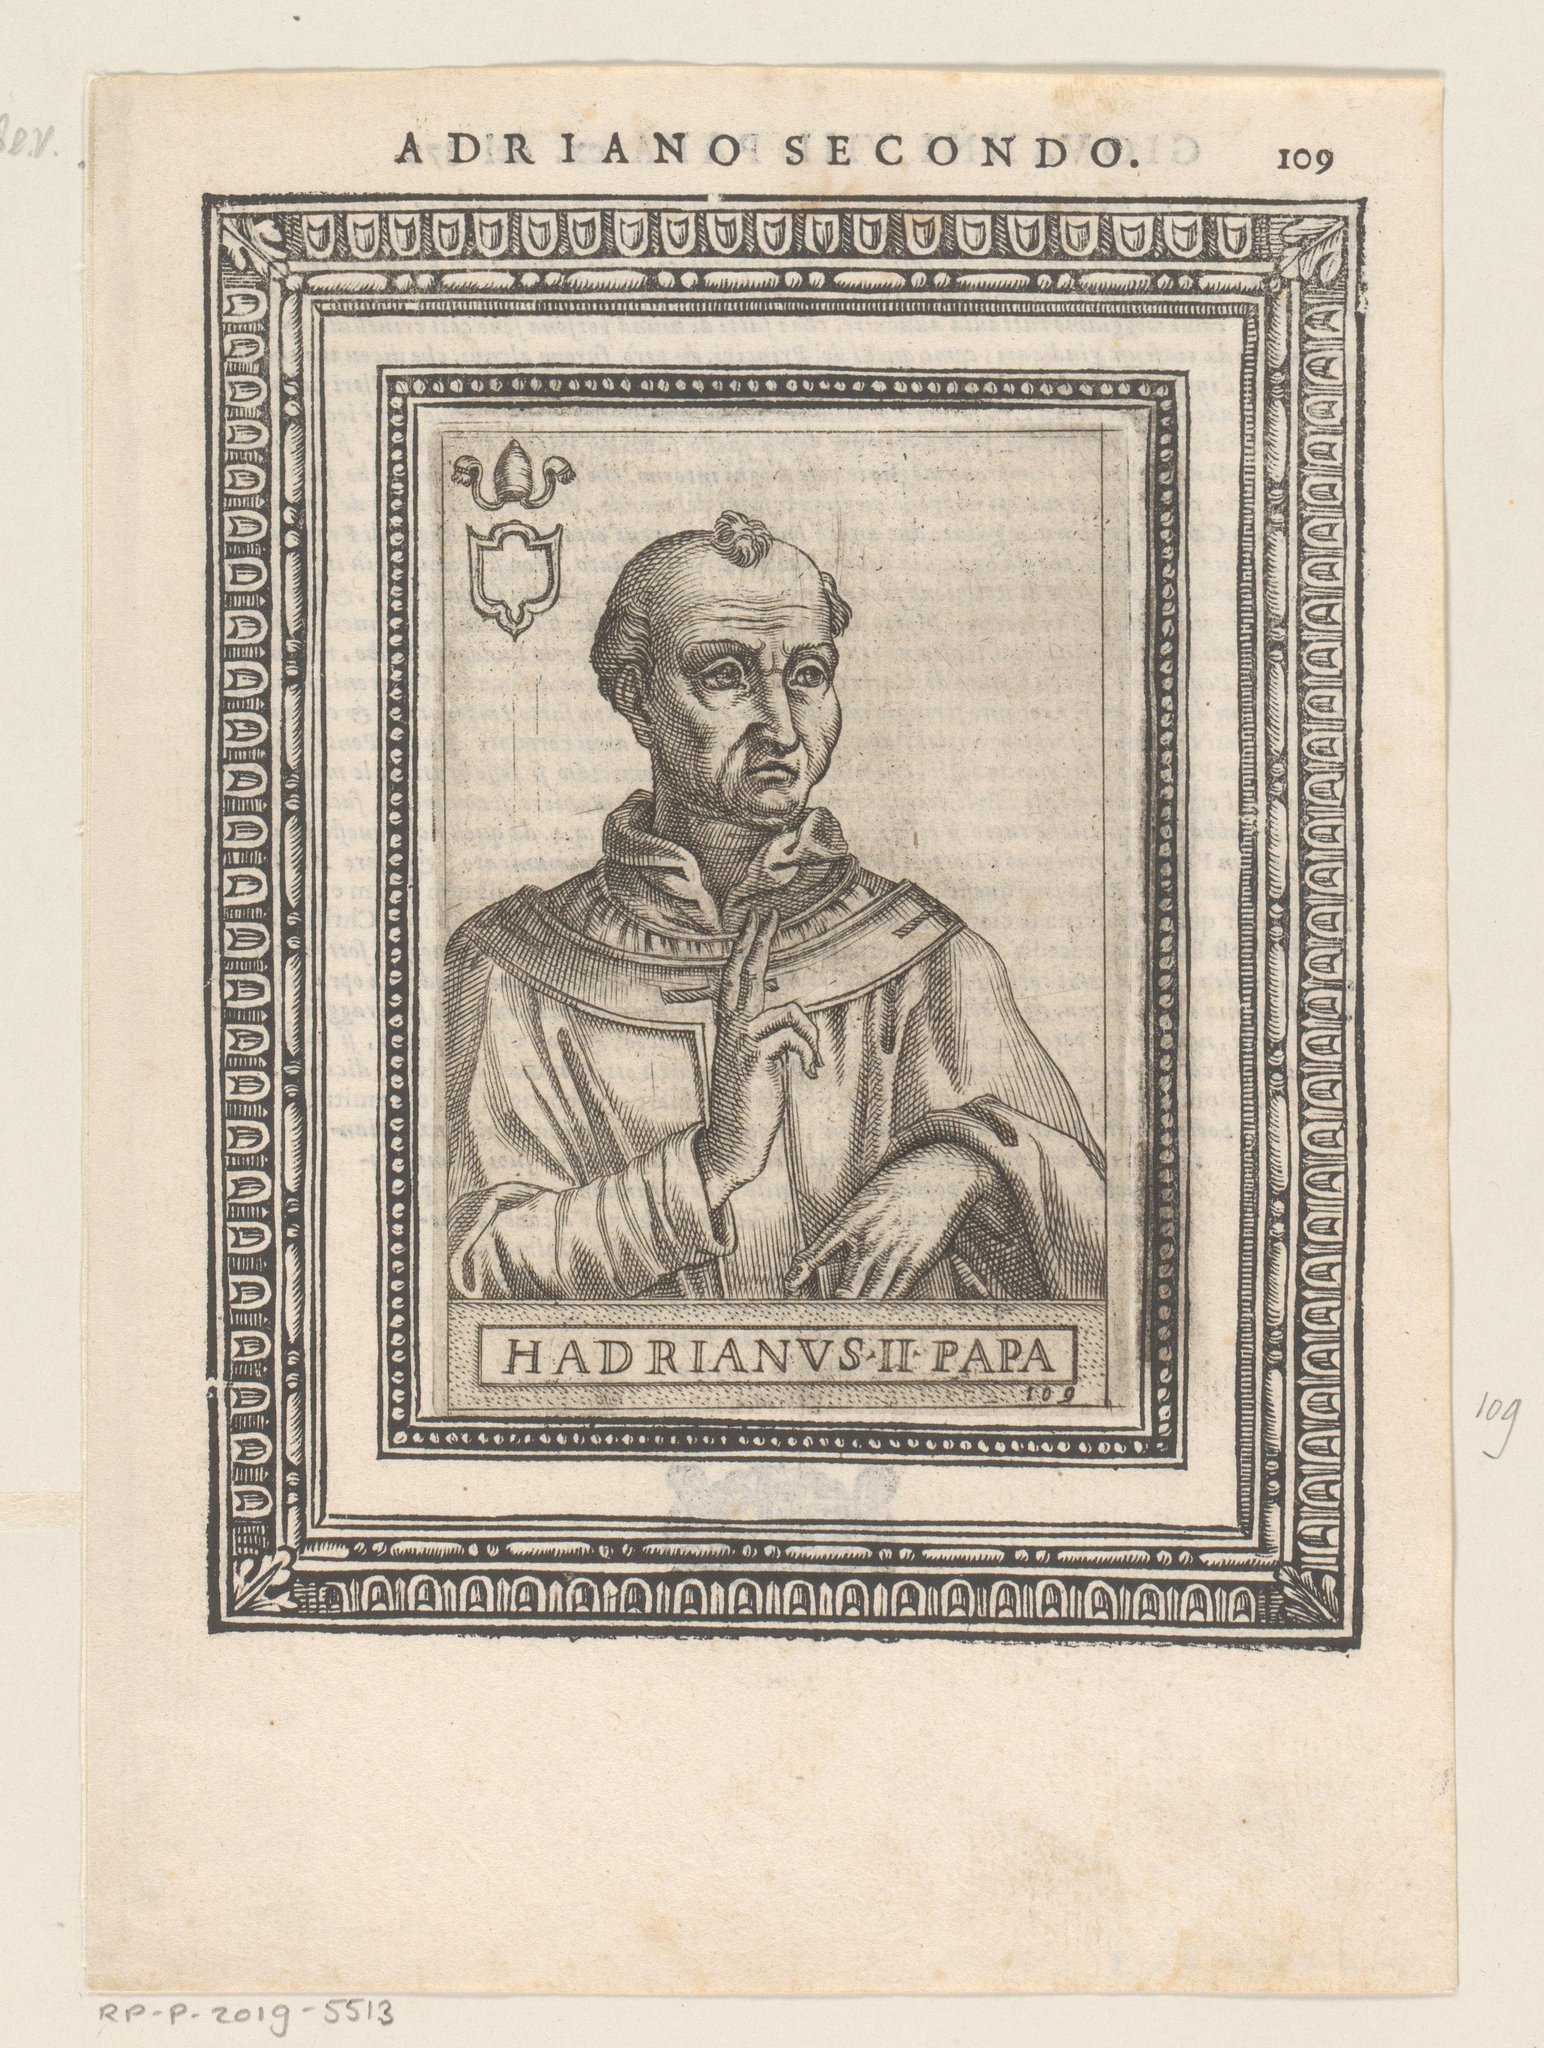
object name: print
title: Portret van paus Adrianus II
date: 1587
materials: paper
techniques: engraving, letterpress printing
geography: rome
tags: historical persons, pope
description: Prent uit: Ciccarelli, Antonio. Le vite de Pontefici di Antonio Ciccarelli (...). Rome: Domenico Basa, 1587. Prent voor het eerst verschenen in: Cavalieri, Giovanni Battista de'. Pontificum romanorum effigies (...). Rome: Domenico Basa en Francesco Zanetti, 1580. Prent ook gebruikt in latere publicaties.